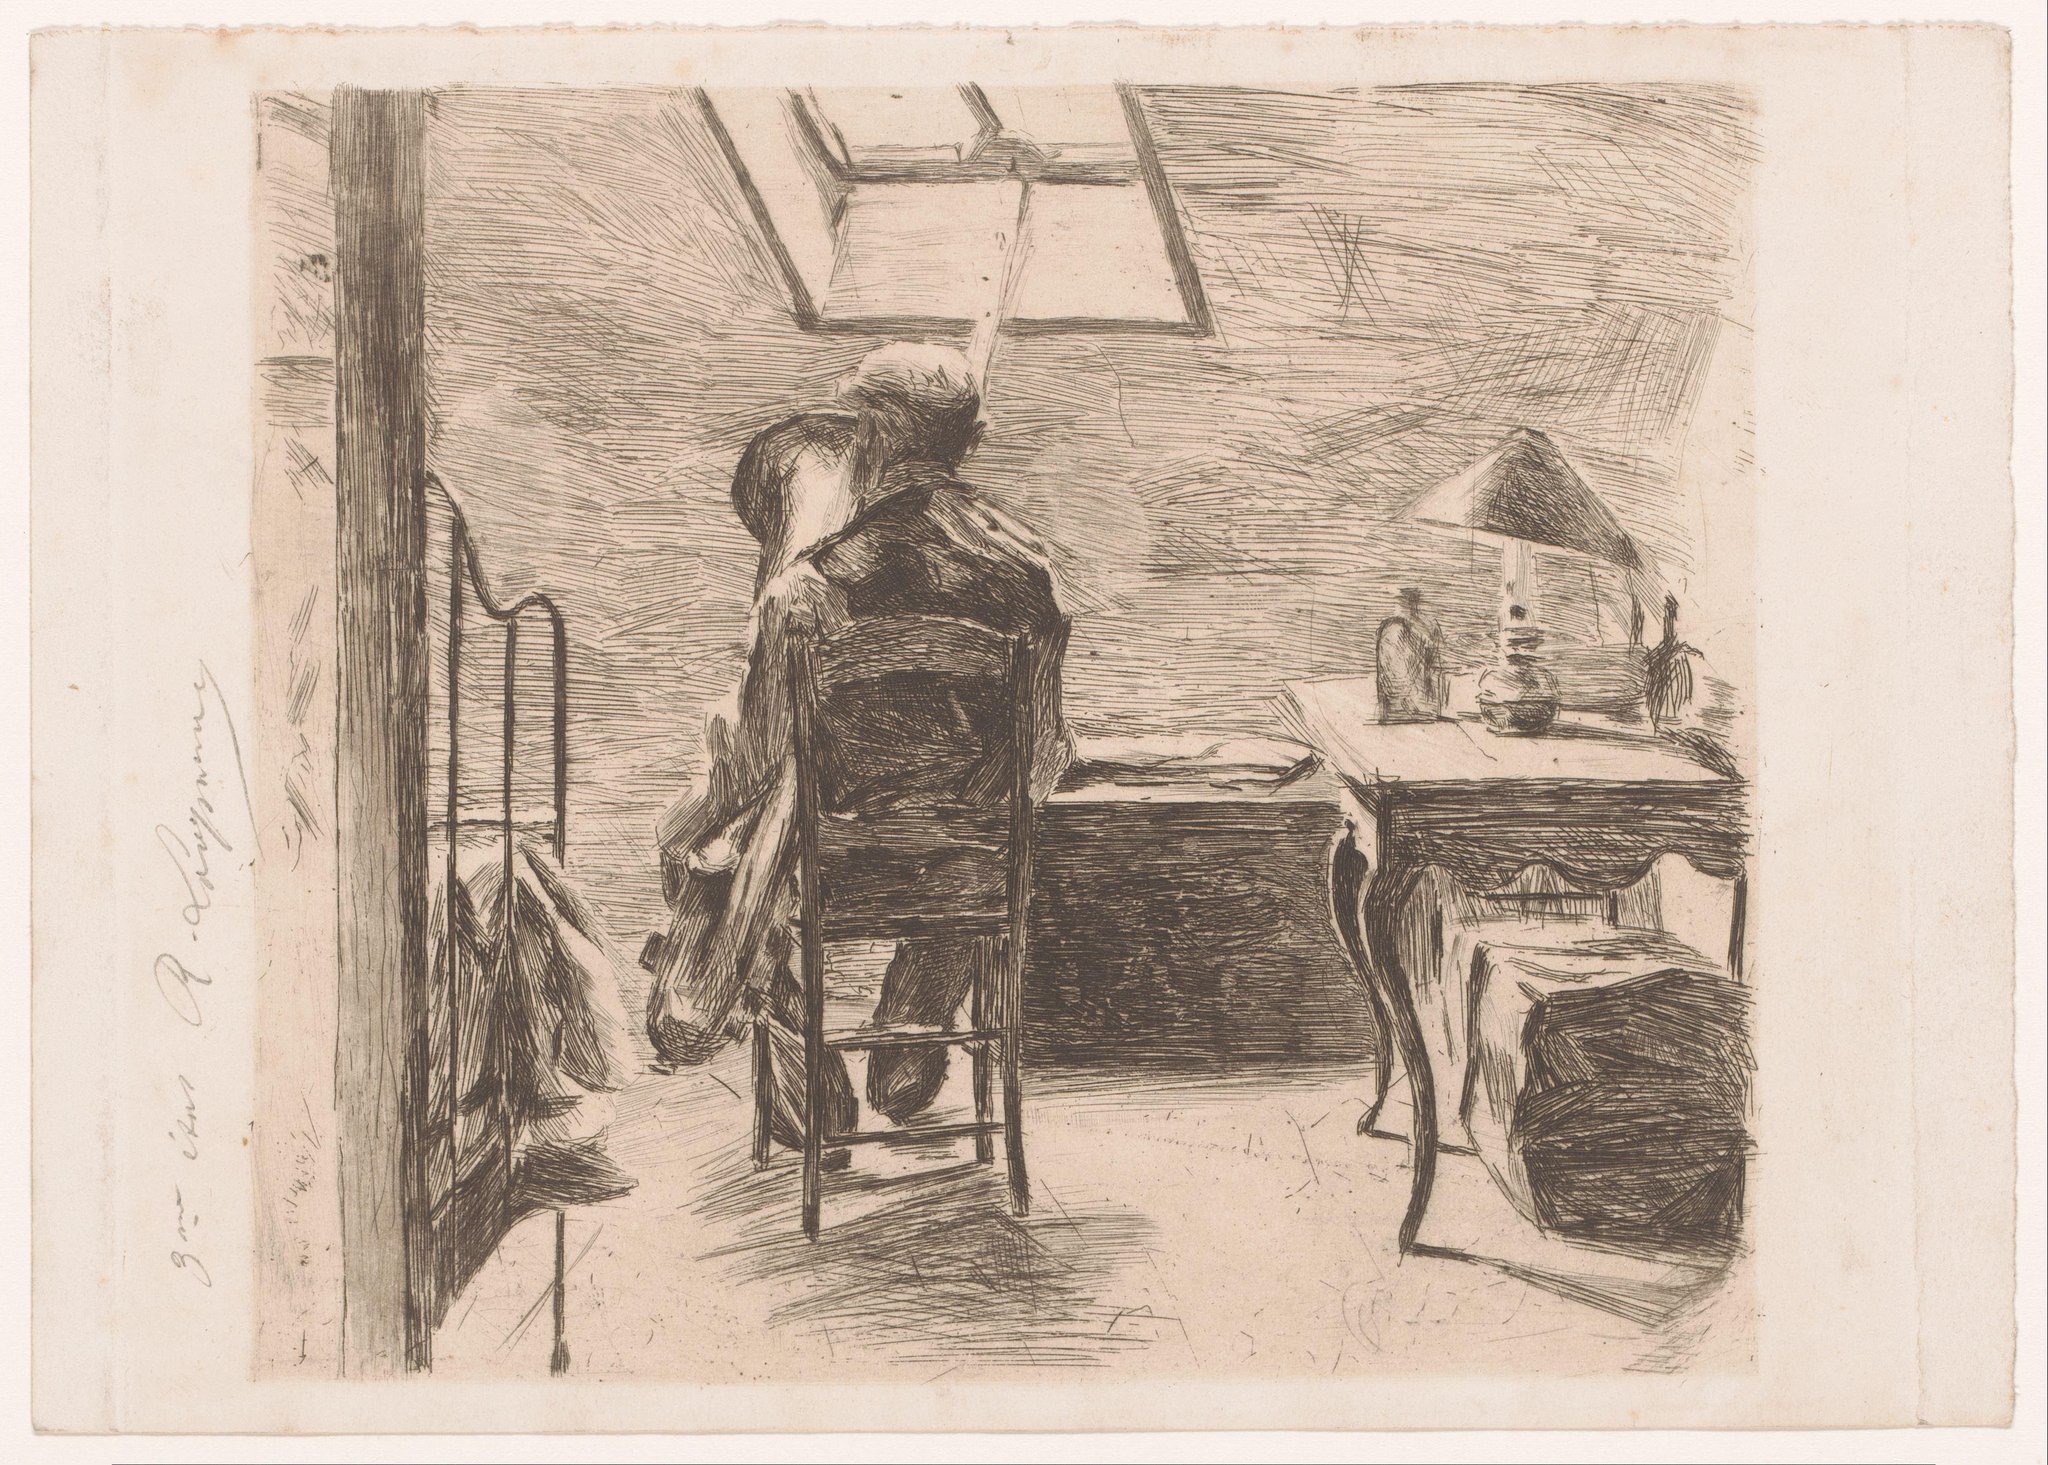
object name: print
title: Tubaspeler op een zolderkamer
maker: romain looymans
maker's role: print maker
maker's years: 1864-1914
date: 1890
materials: paper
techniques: etching, intaglio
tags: attic, loft, horn, trumpet, cornet, trombone, tuba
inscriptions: collector's mark: Lugt 2228, annotation: ‘3me état’